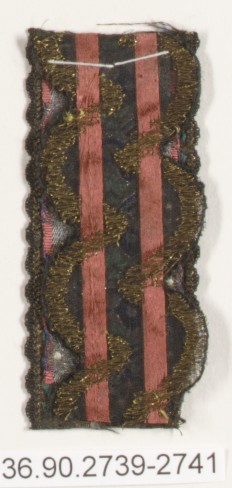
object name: ribbon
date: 1801-1900